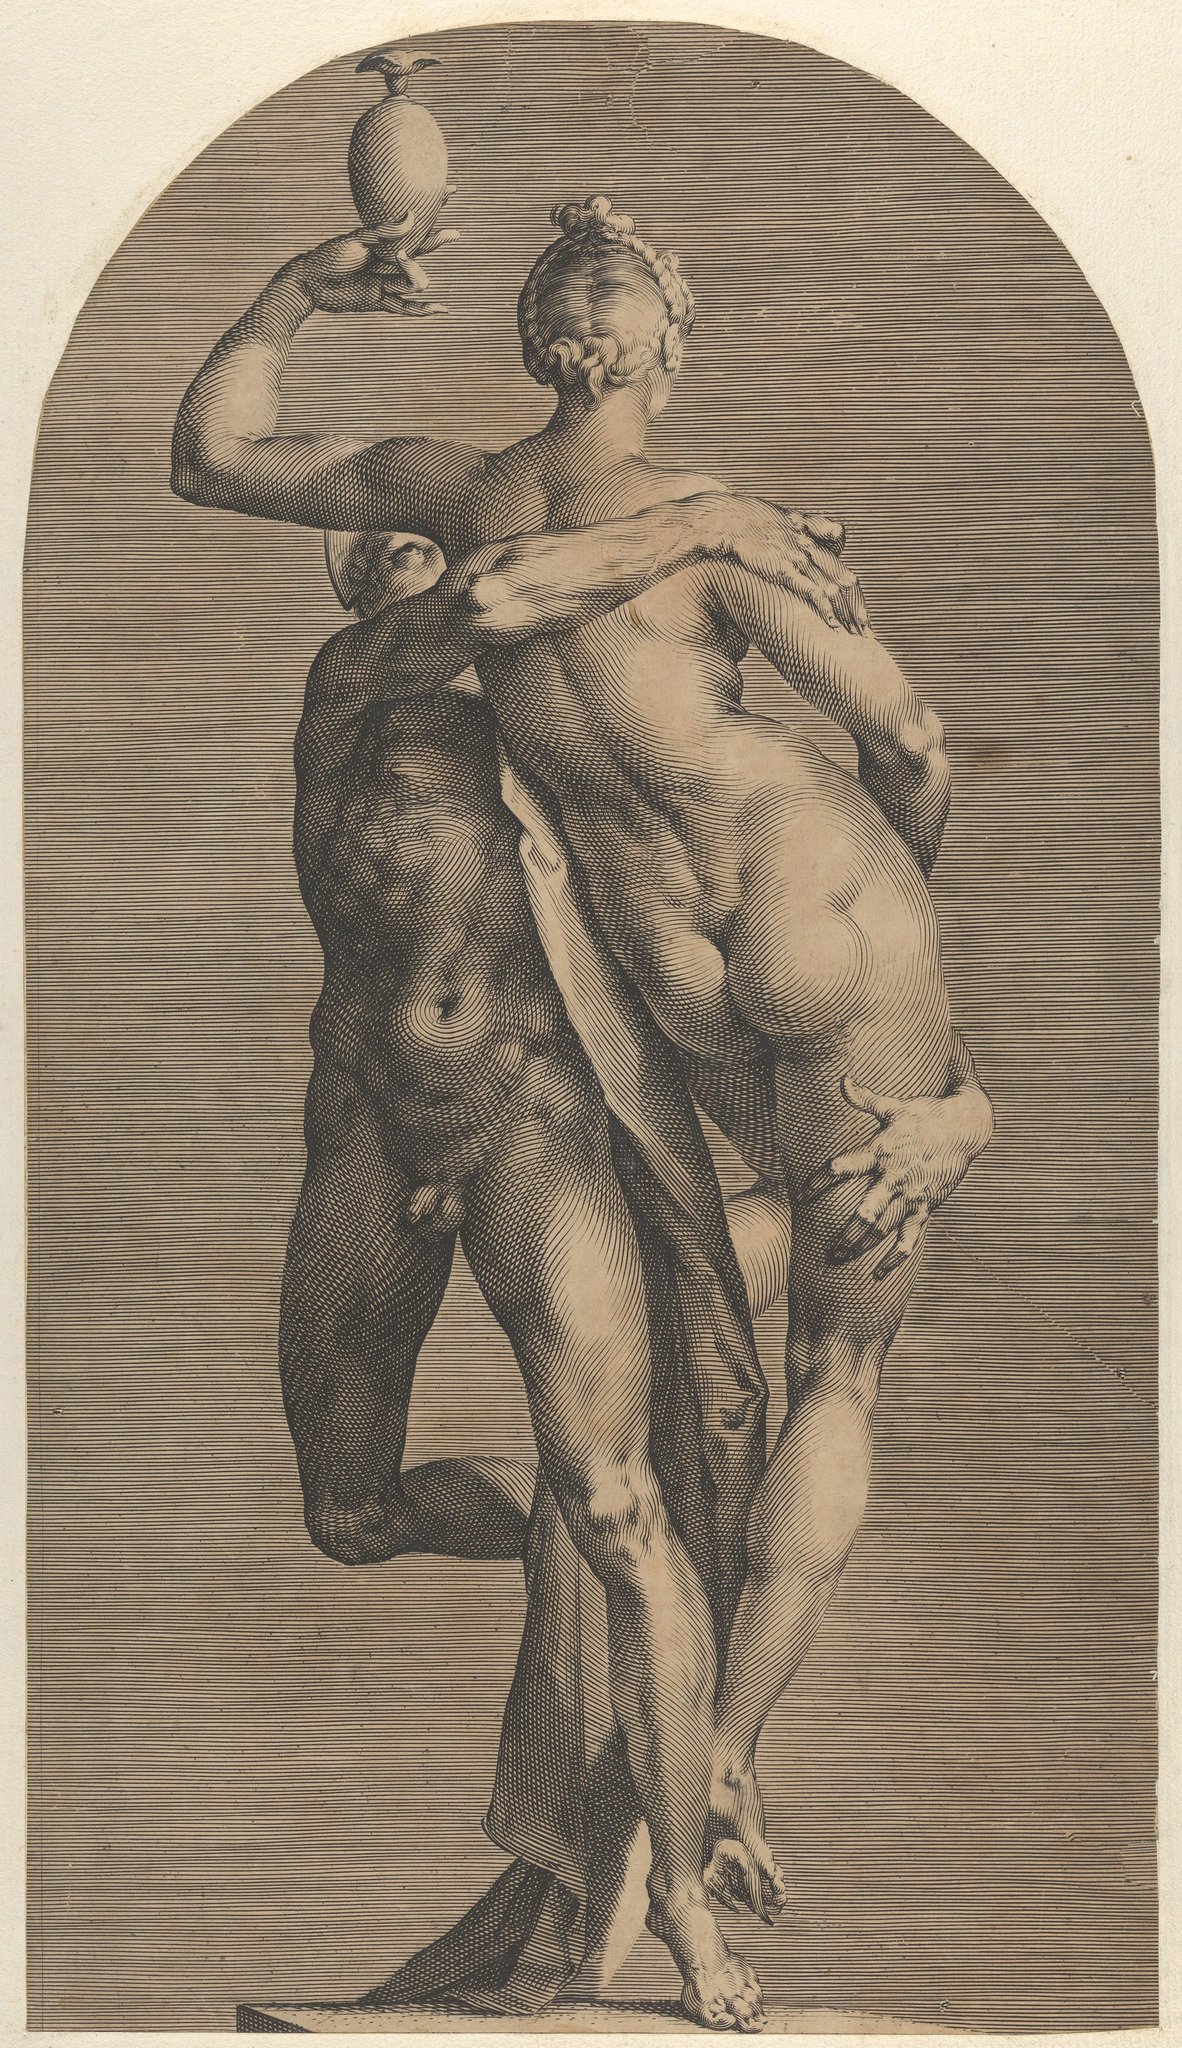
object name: print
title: Mercury Abducting Psyche (view with Psyche from behind), from a set of three views of the sculpture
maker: jan muller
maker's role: artist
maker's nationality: netherlandish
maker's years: 1571-1628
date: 1593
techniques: engraving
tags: psyche,mercury